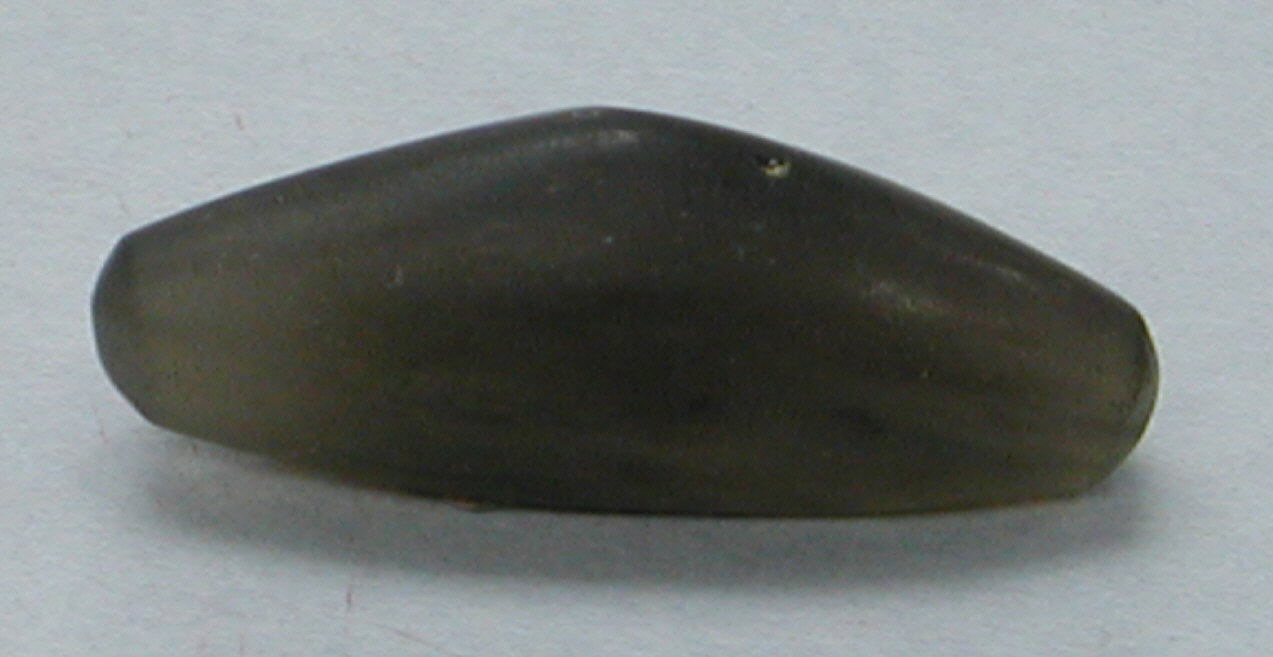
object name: ritual stone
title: Stone Pulidor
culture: mexican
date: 1501-1600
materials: stone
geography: mexico